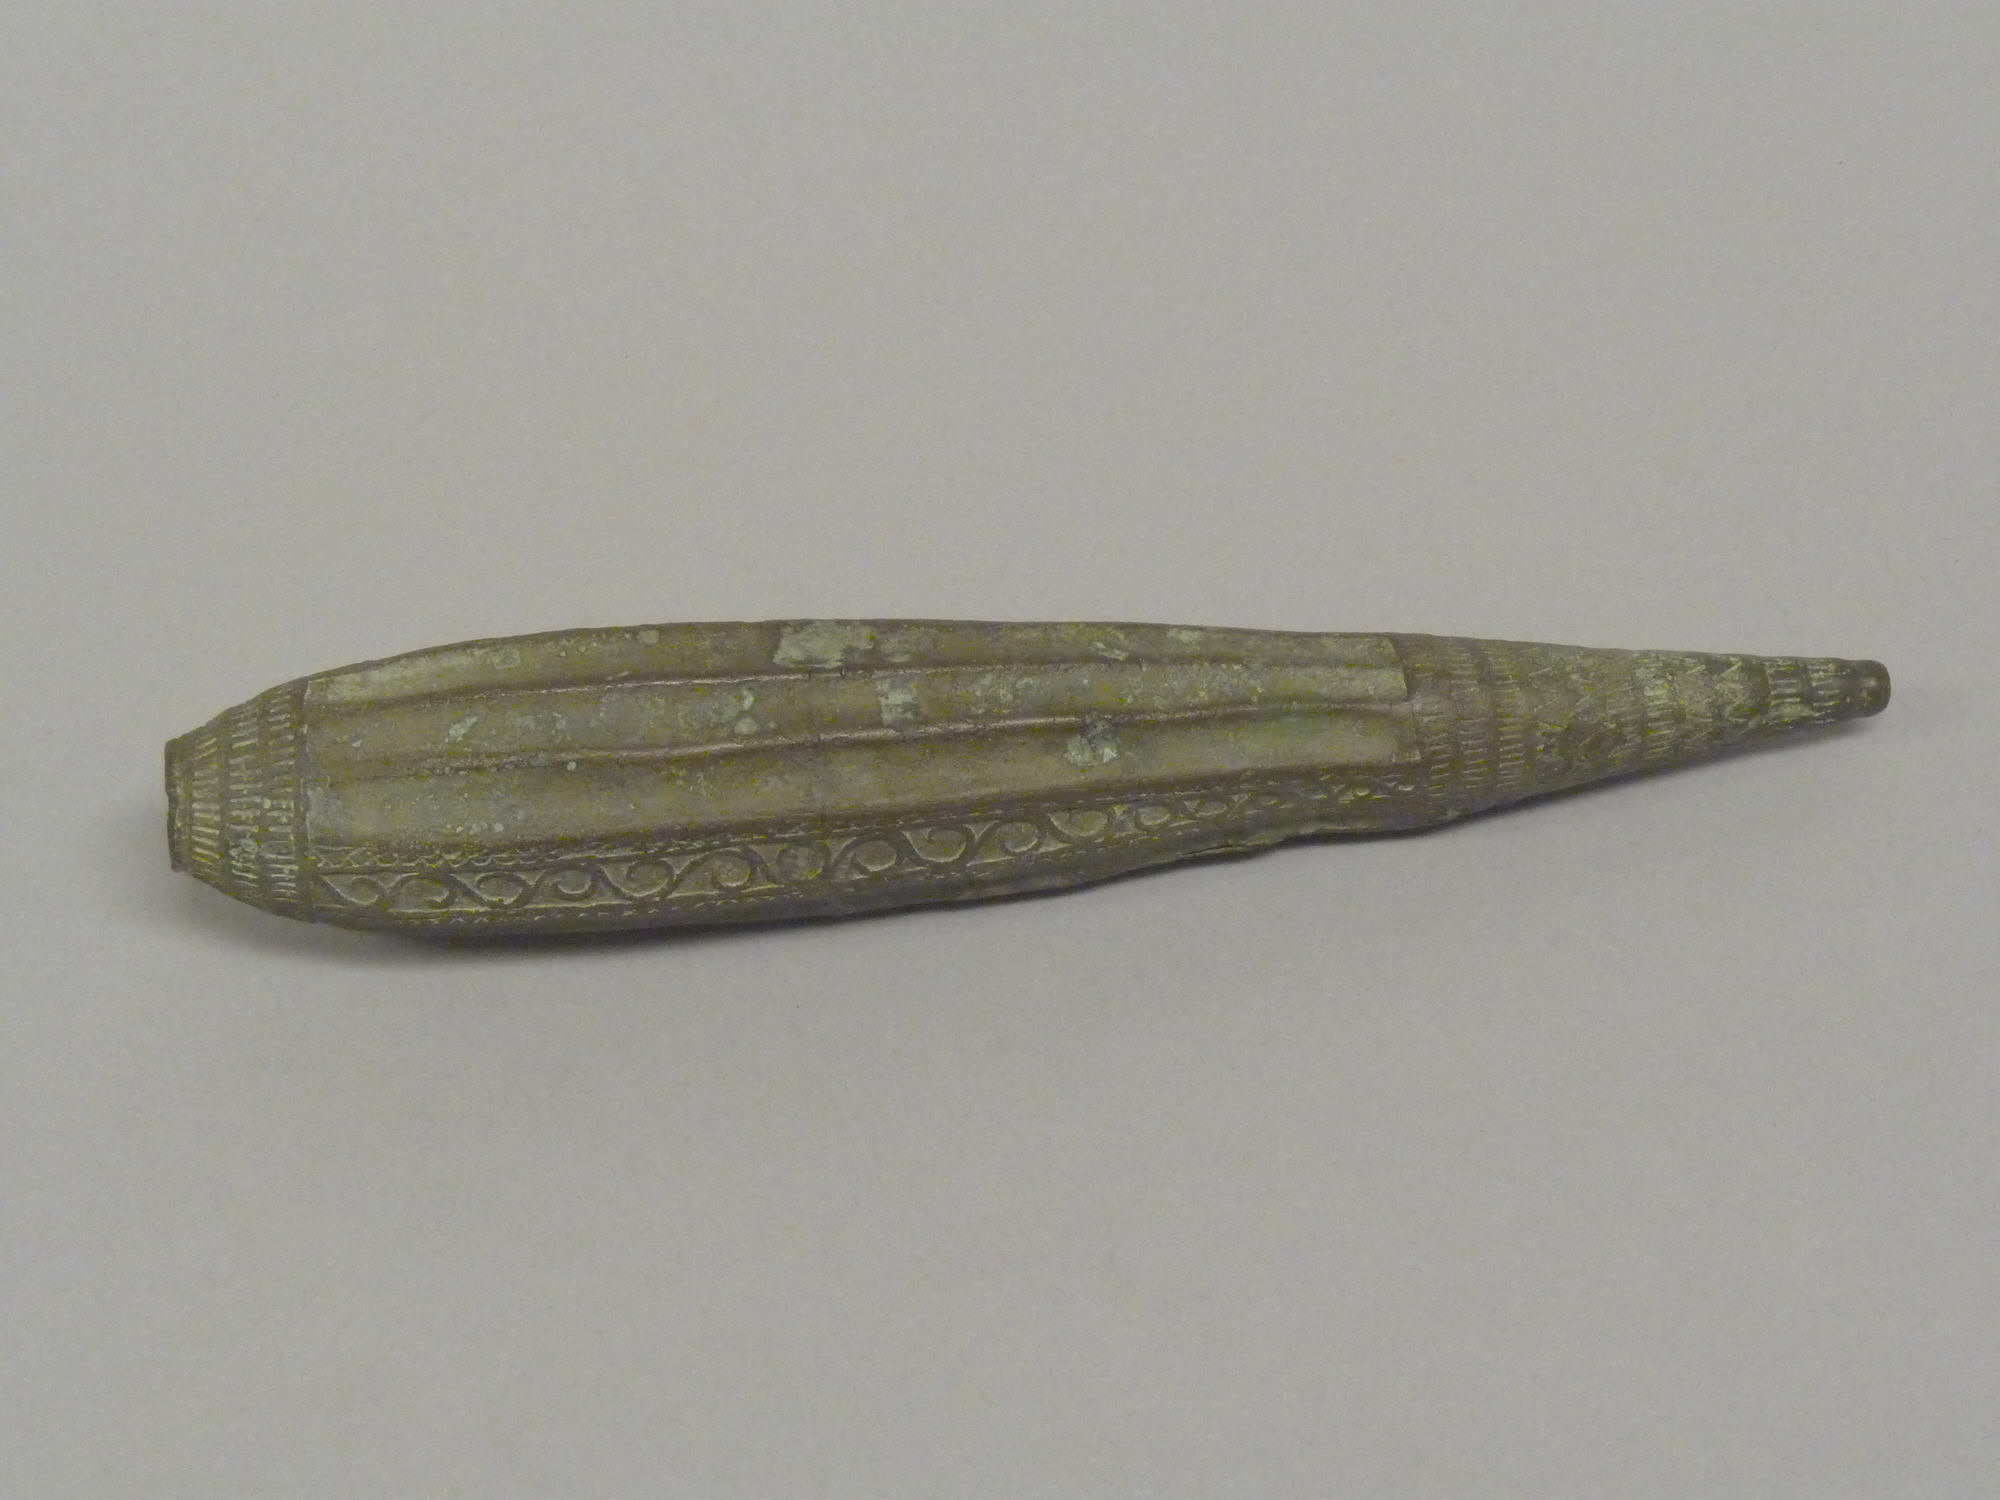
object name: vessel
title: Lime Vessel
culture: indonesian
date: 500 BCE-300 CE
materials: bronze